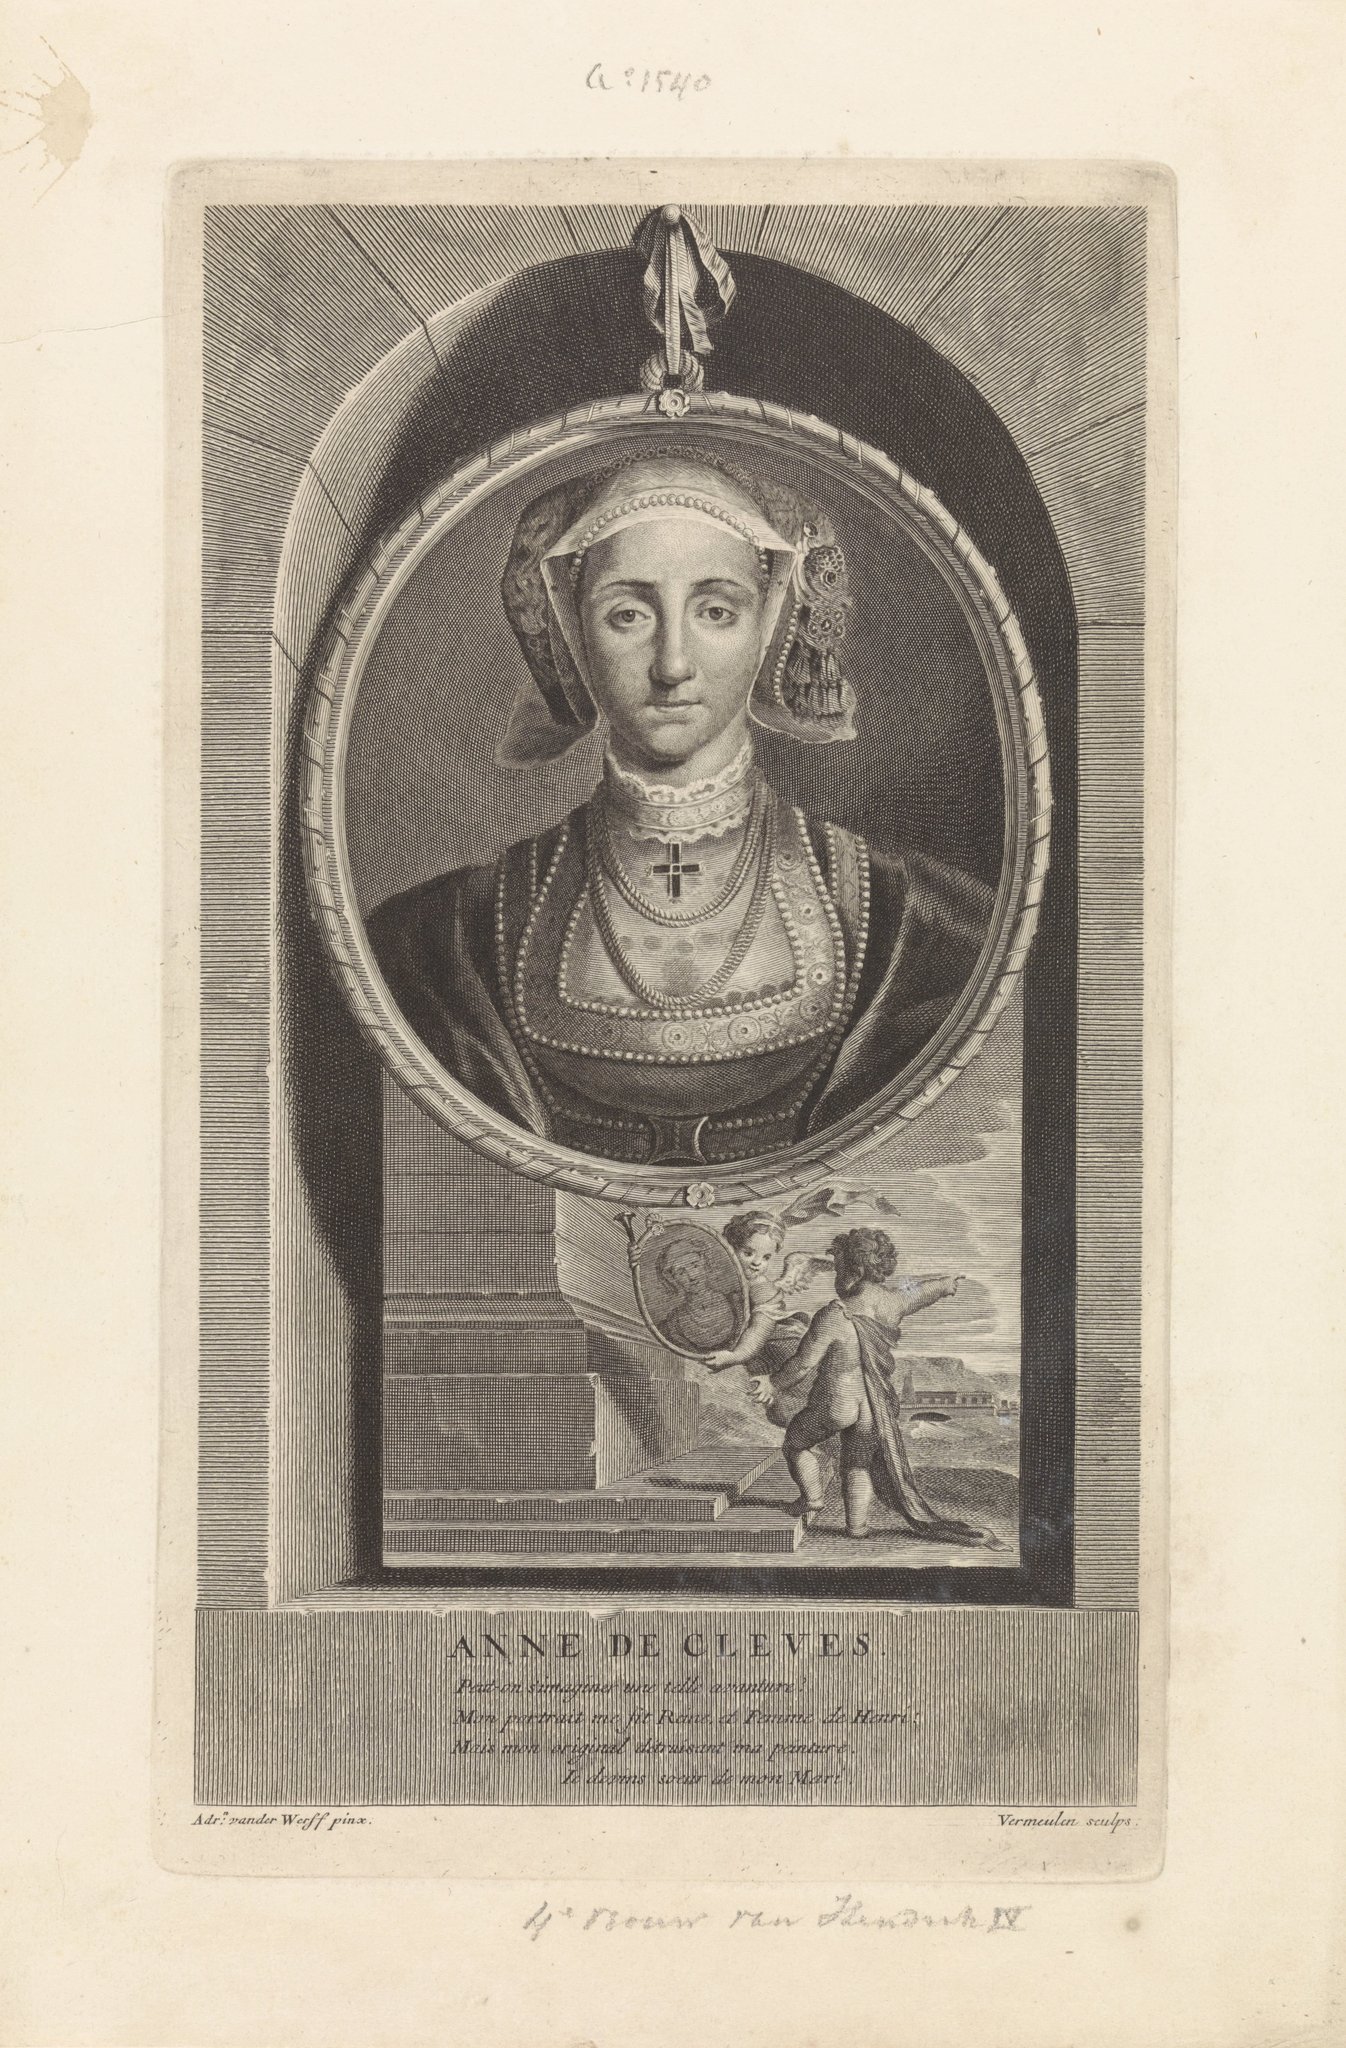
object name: print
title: Portret van Anna van Kleef, koningin van Engeland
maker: adriaen van der werff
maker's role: draughtsman, painter, print maker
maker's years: 1659-1722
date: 1697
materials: paper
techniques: engraving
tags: london, cupids: 'amores', 'amoretti', 'putti'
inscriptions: collector's mark: Lugt 2228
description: Prent ook gebruikt als boekillustratie in: Larrey, Isaac de. Histoire d'Angleterre, d'Ecosse, et d'Irlande. 4 dln. Rotterdam: Reinier Leers, 1697-1713.